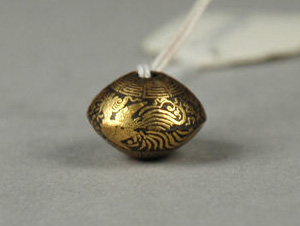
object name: ojime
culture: japanese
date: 1801-1900